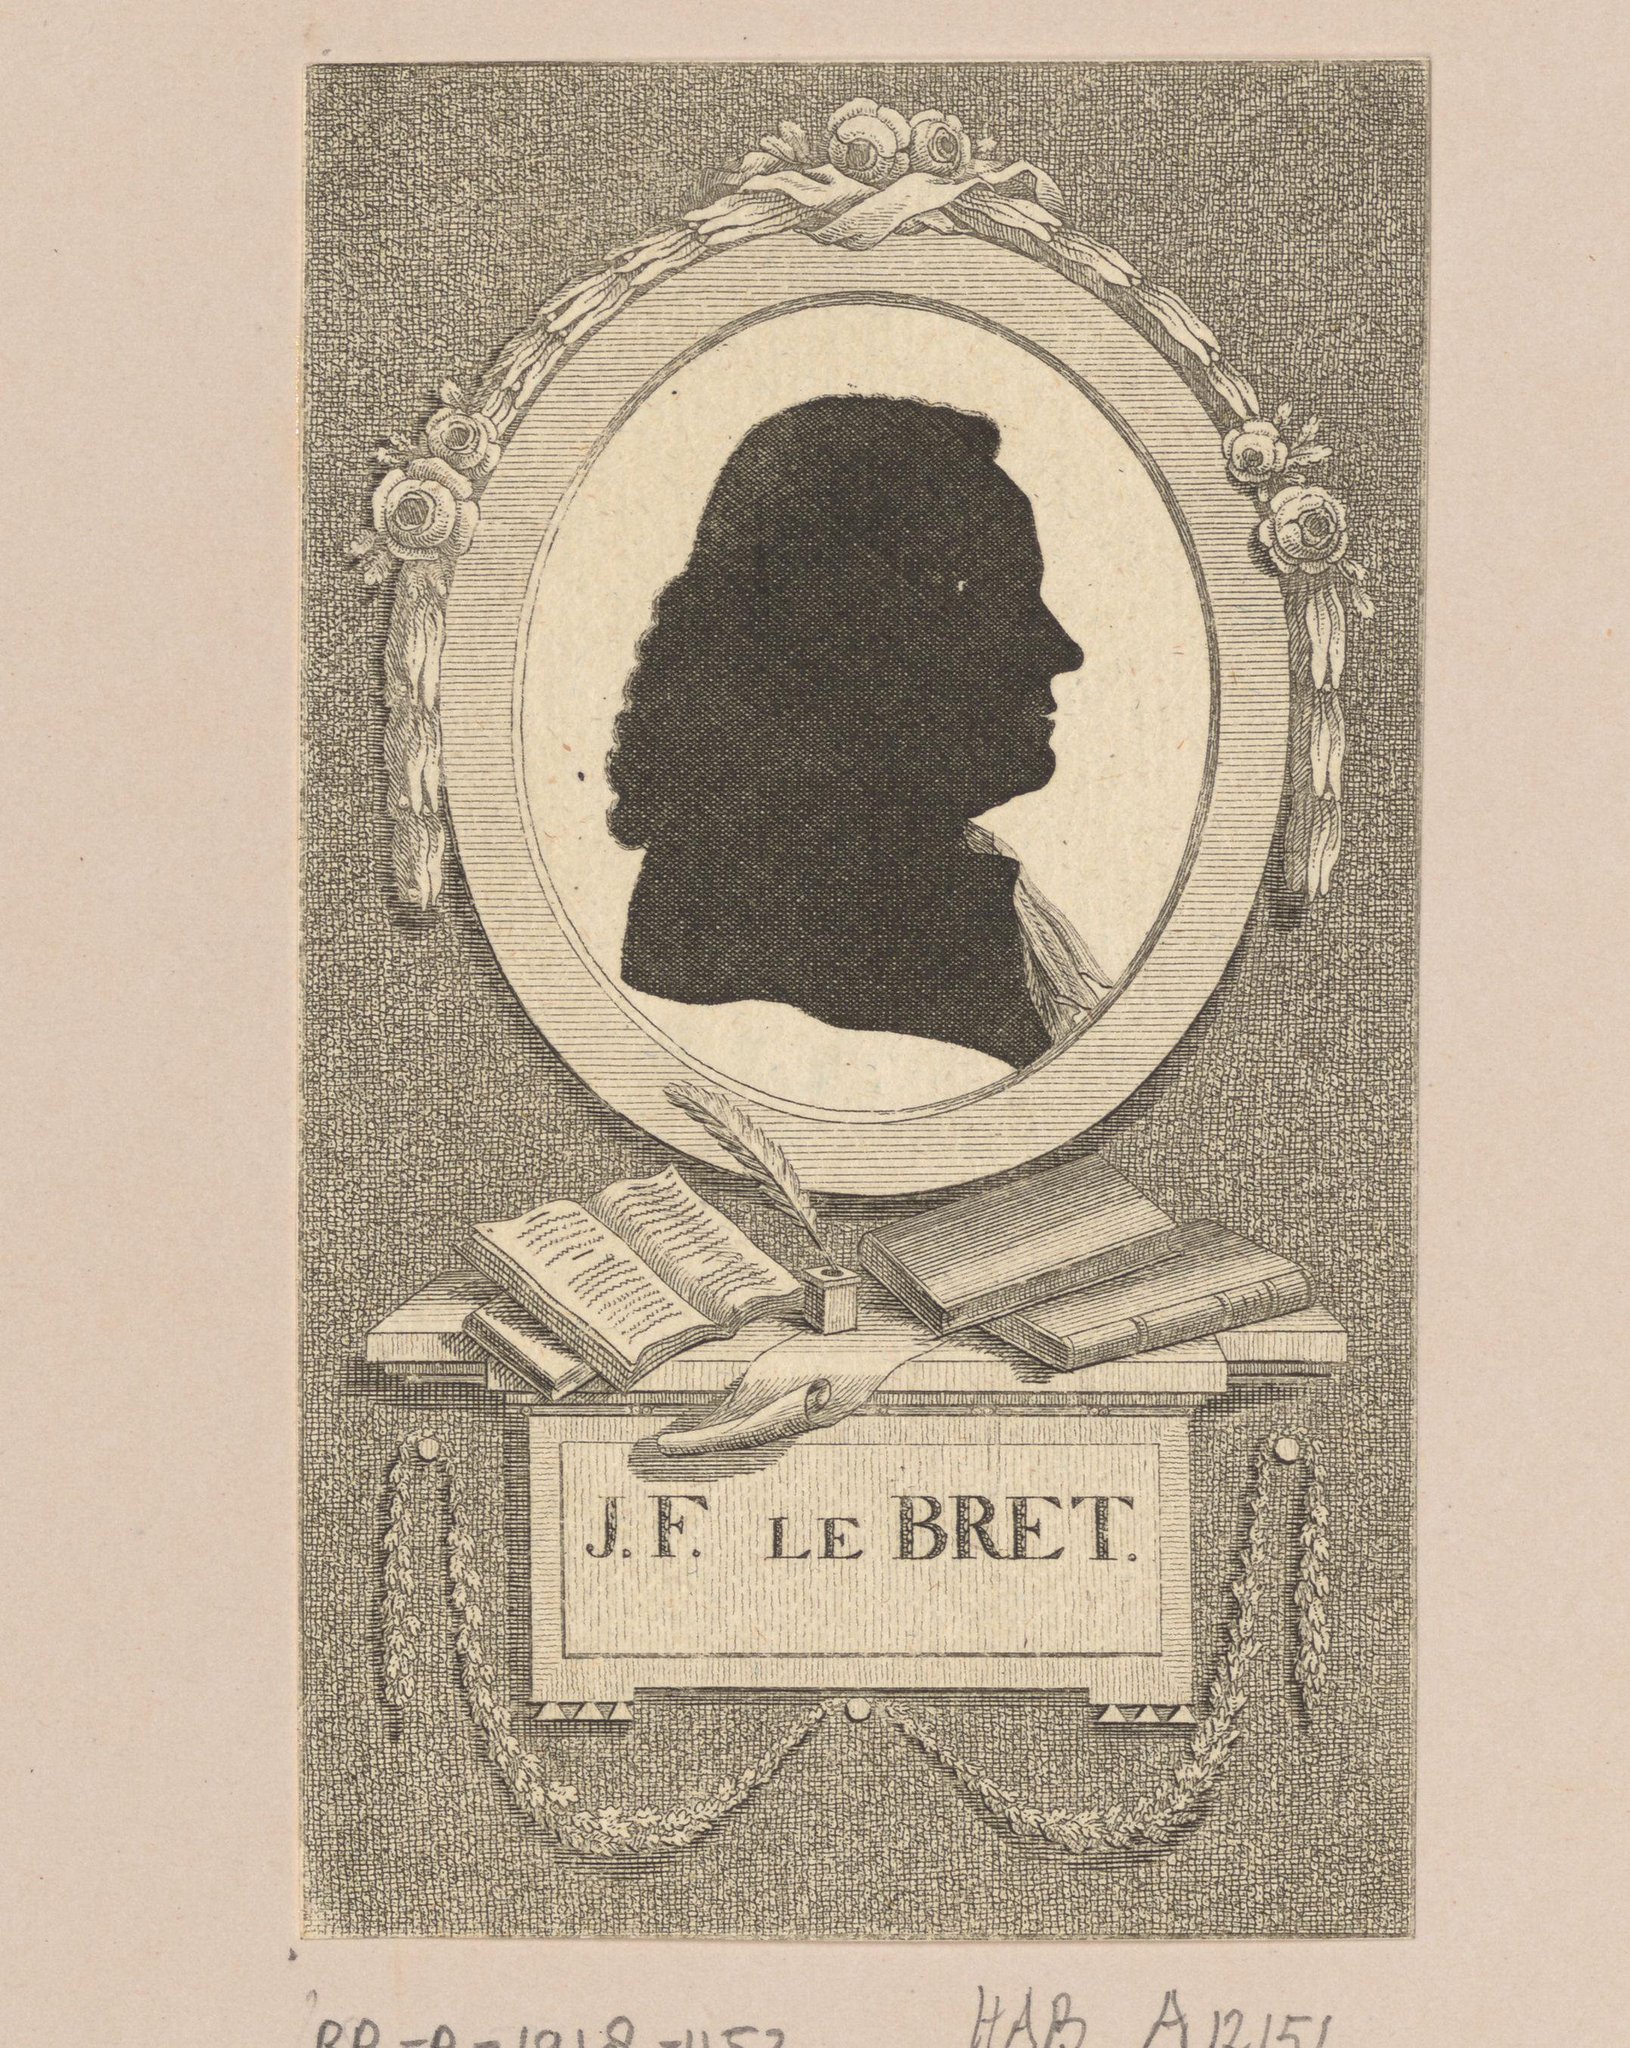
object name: print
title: Silhouetportret van Johann Friedrich Le Bret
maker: christoph gebhard grape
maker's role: print maker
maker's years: 1761-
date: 1771-1834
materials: paper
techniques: etching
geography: germany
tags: theologian, ornament ~ medallion, historical persons, book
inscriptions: collector's mark: Lugt 2233